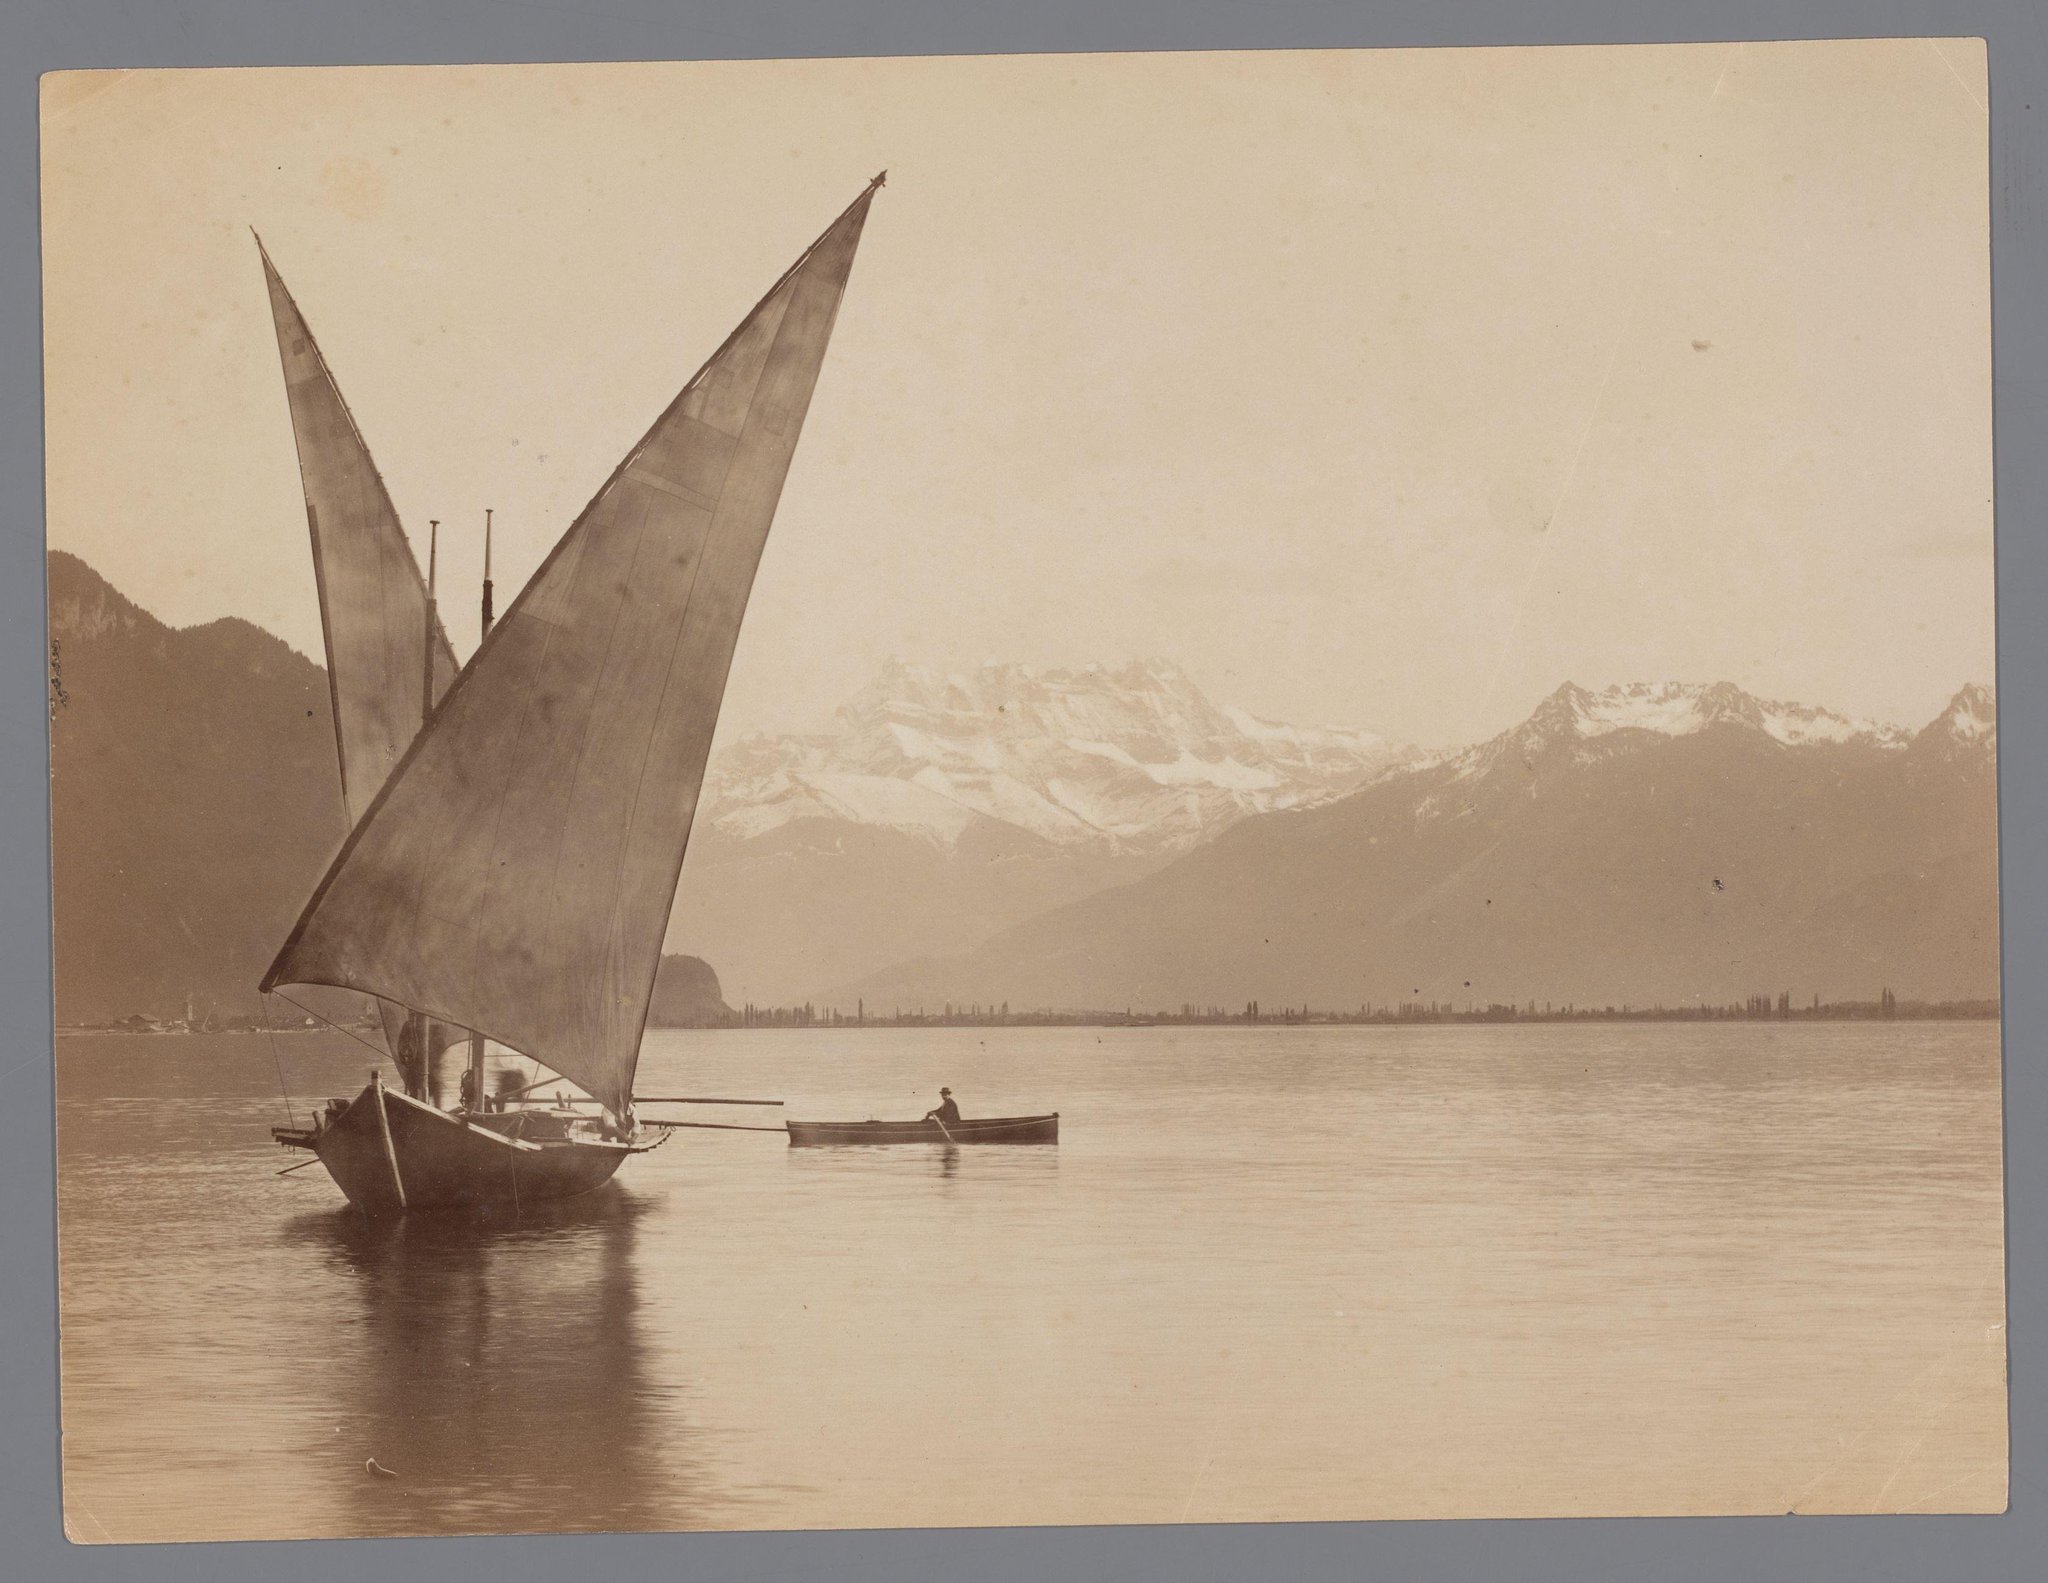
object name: photograph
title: Zeilschip en rooiboot in een meer, gletsjers op de achtergrond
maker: Anonymous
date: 1890-1915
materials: paper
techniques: albumen print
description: Zeilschip links in beeld en rooiboot met één roeier in een meer, gletsjers op de achtergrond in Zwitserland, Oostenrijk, Italië of Duitsland.